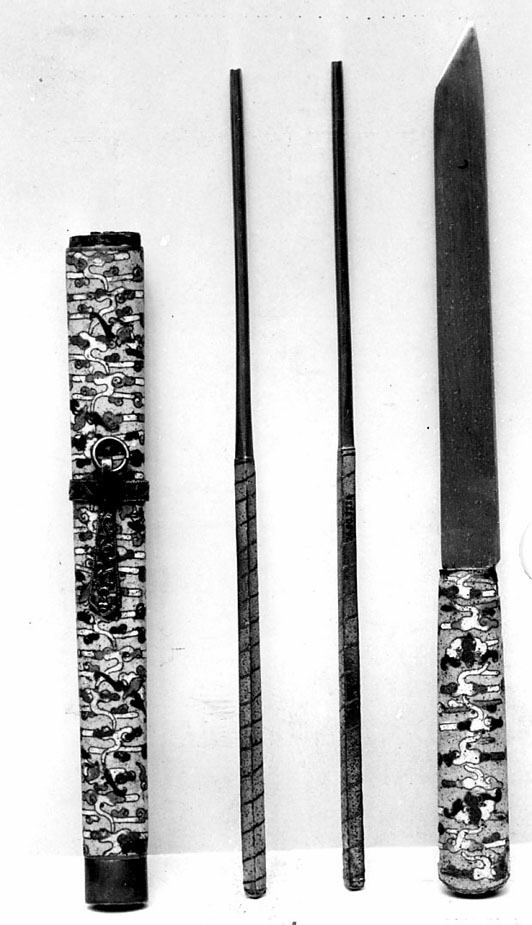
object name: knife, holder, chopstick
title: Knife with Holder and Two Chopsticks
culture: chinese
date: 1667-1733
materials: enamel